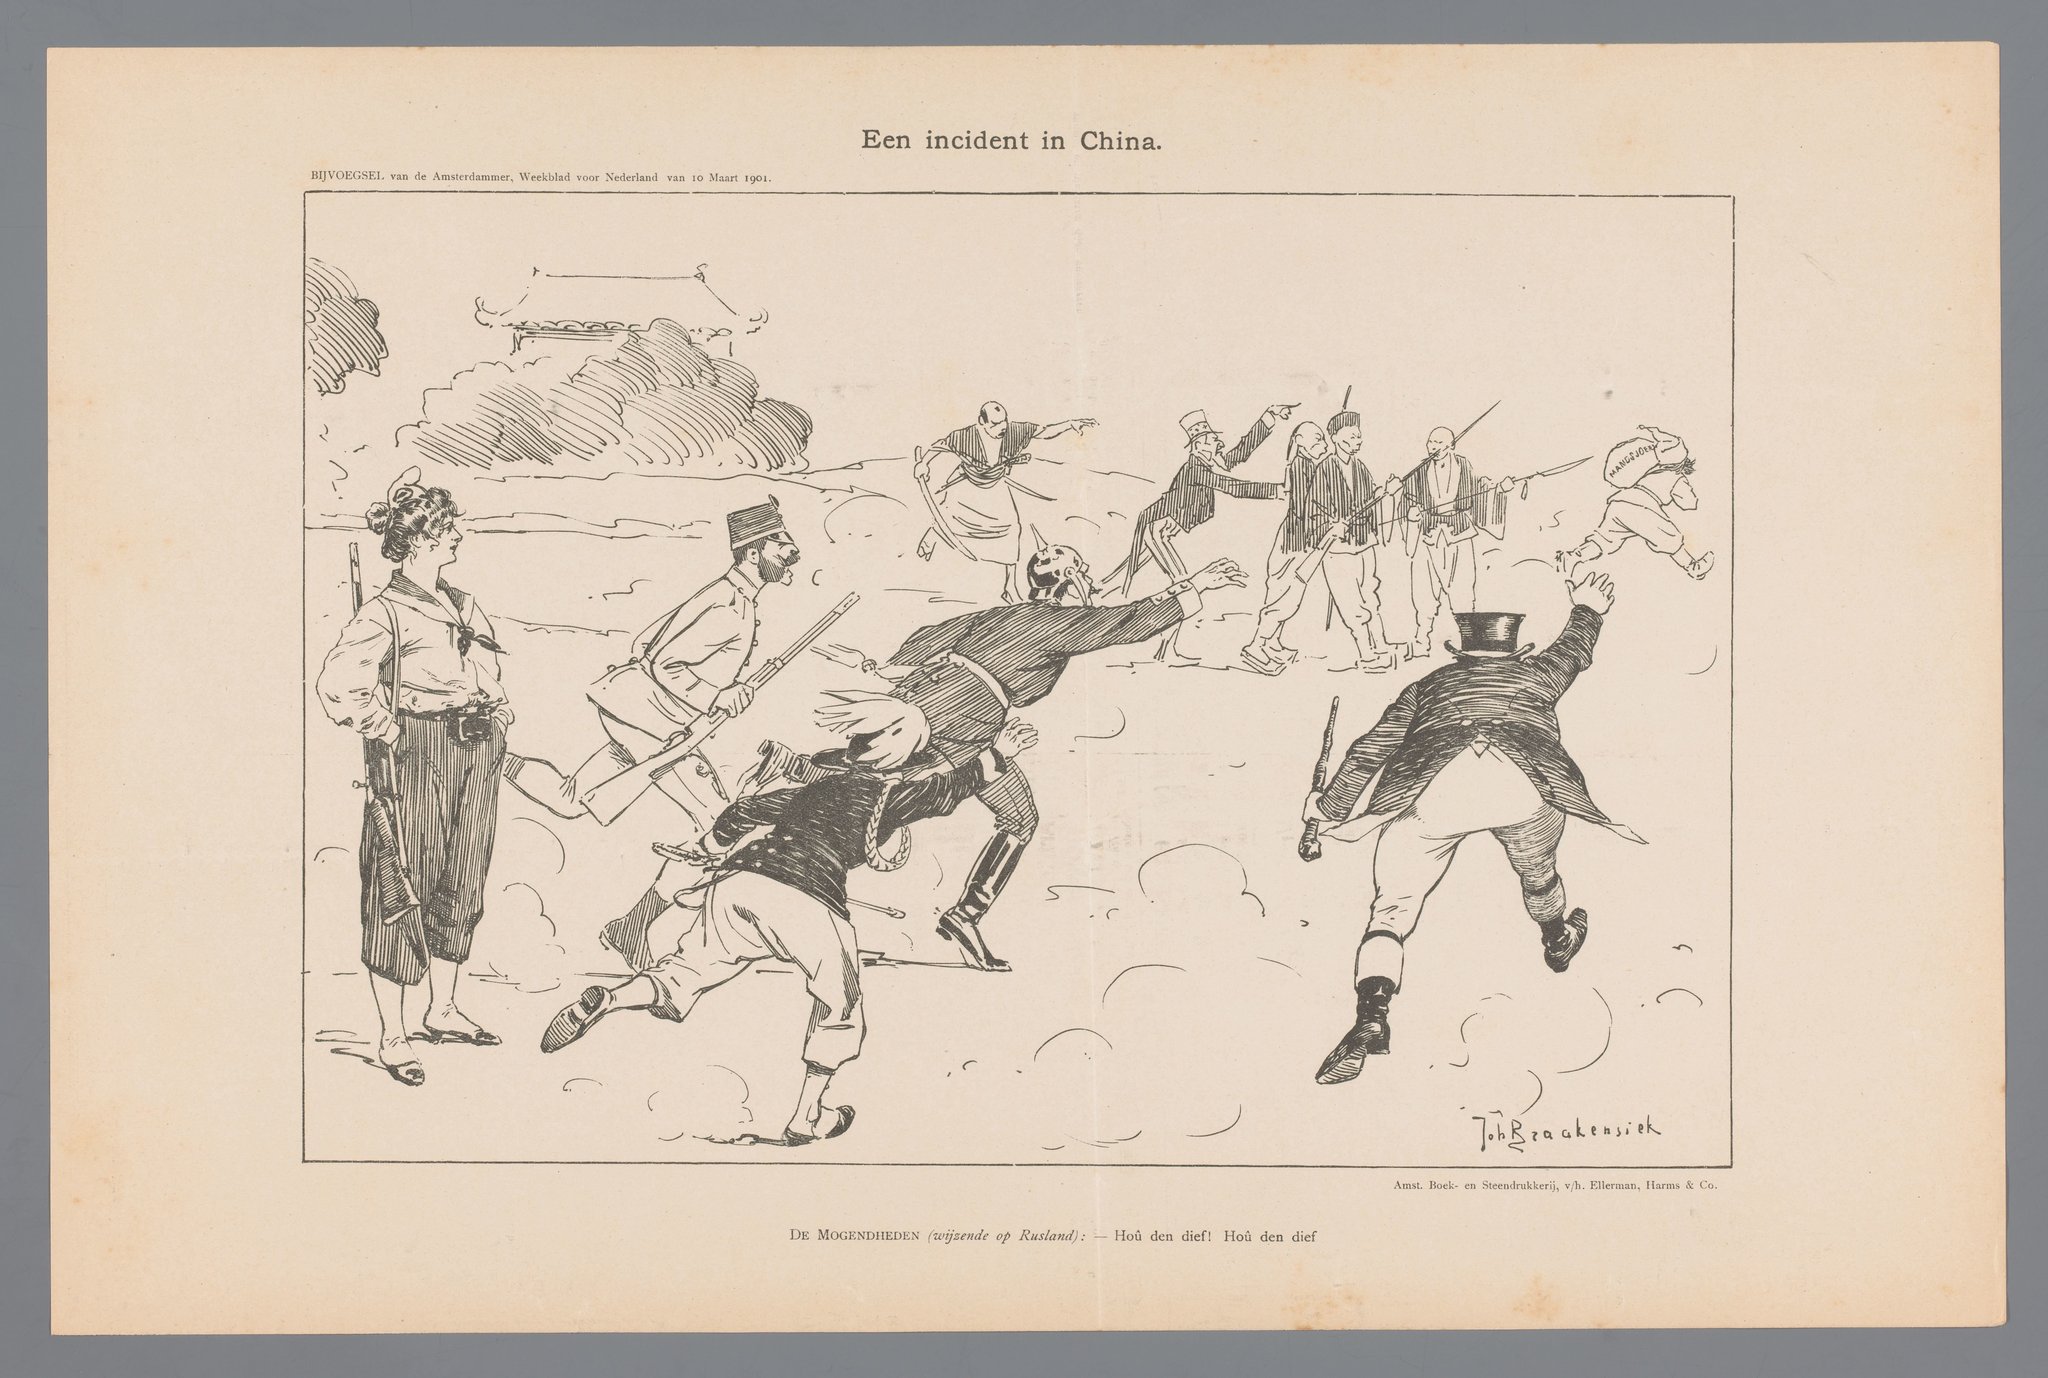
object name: cartoon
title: Een incident in China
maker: johan braakensiek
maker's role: draughtsman, print maker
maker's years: 1858-1940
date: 1901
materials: paper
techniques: lithograph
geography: amsterdam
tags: ruler, sovereign, personifications of countries, nations, states, districts, etc. (+ nation; national), political caricatures and satires, china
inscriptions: date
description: Prent uit het bijvoegsel van: De Amsterdammer. Weekblad voor Nederland, 10 maart 1901.